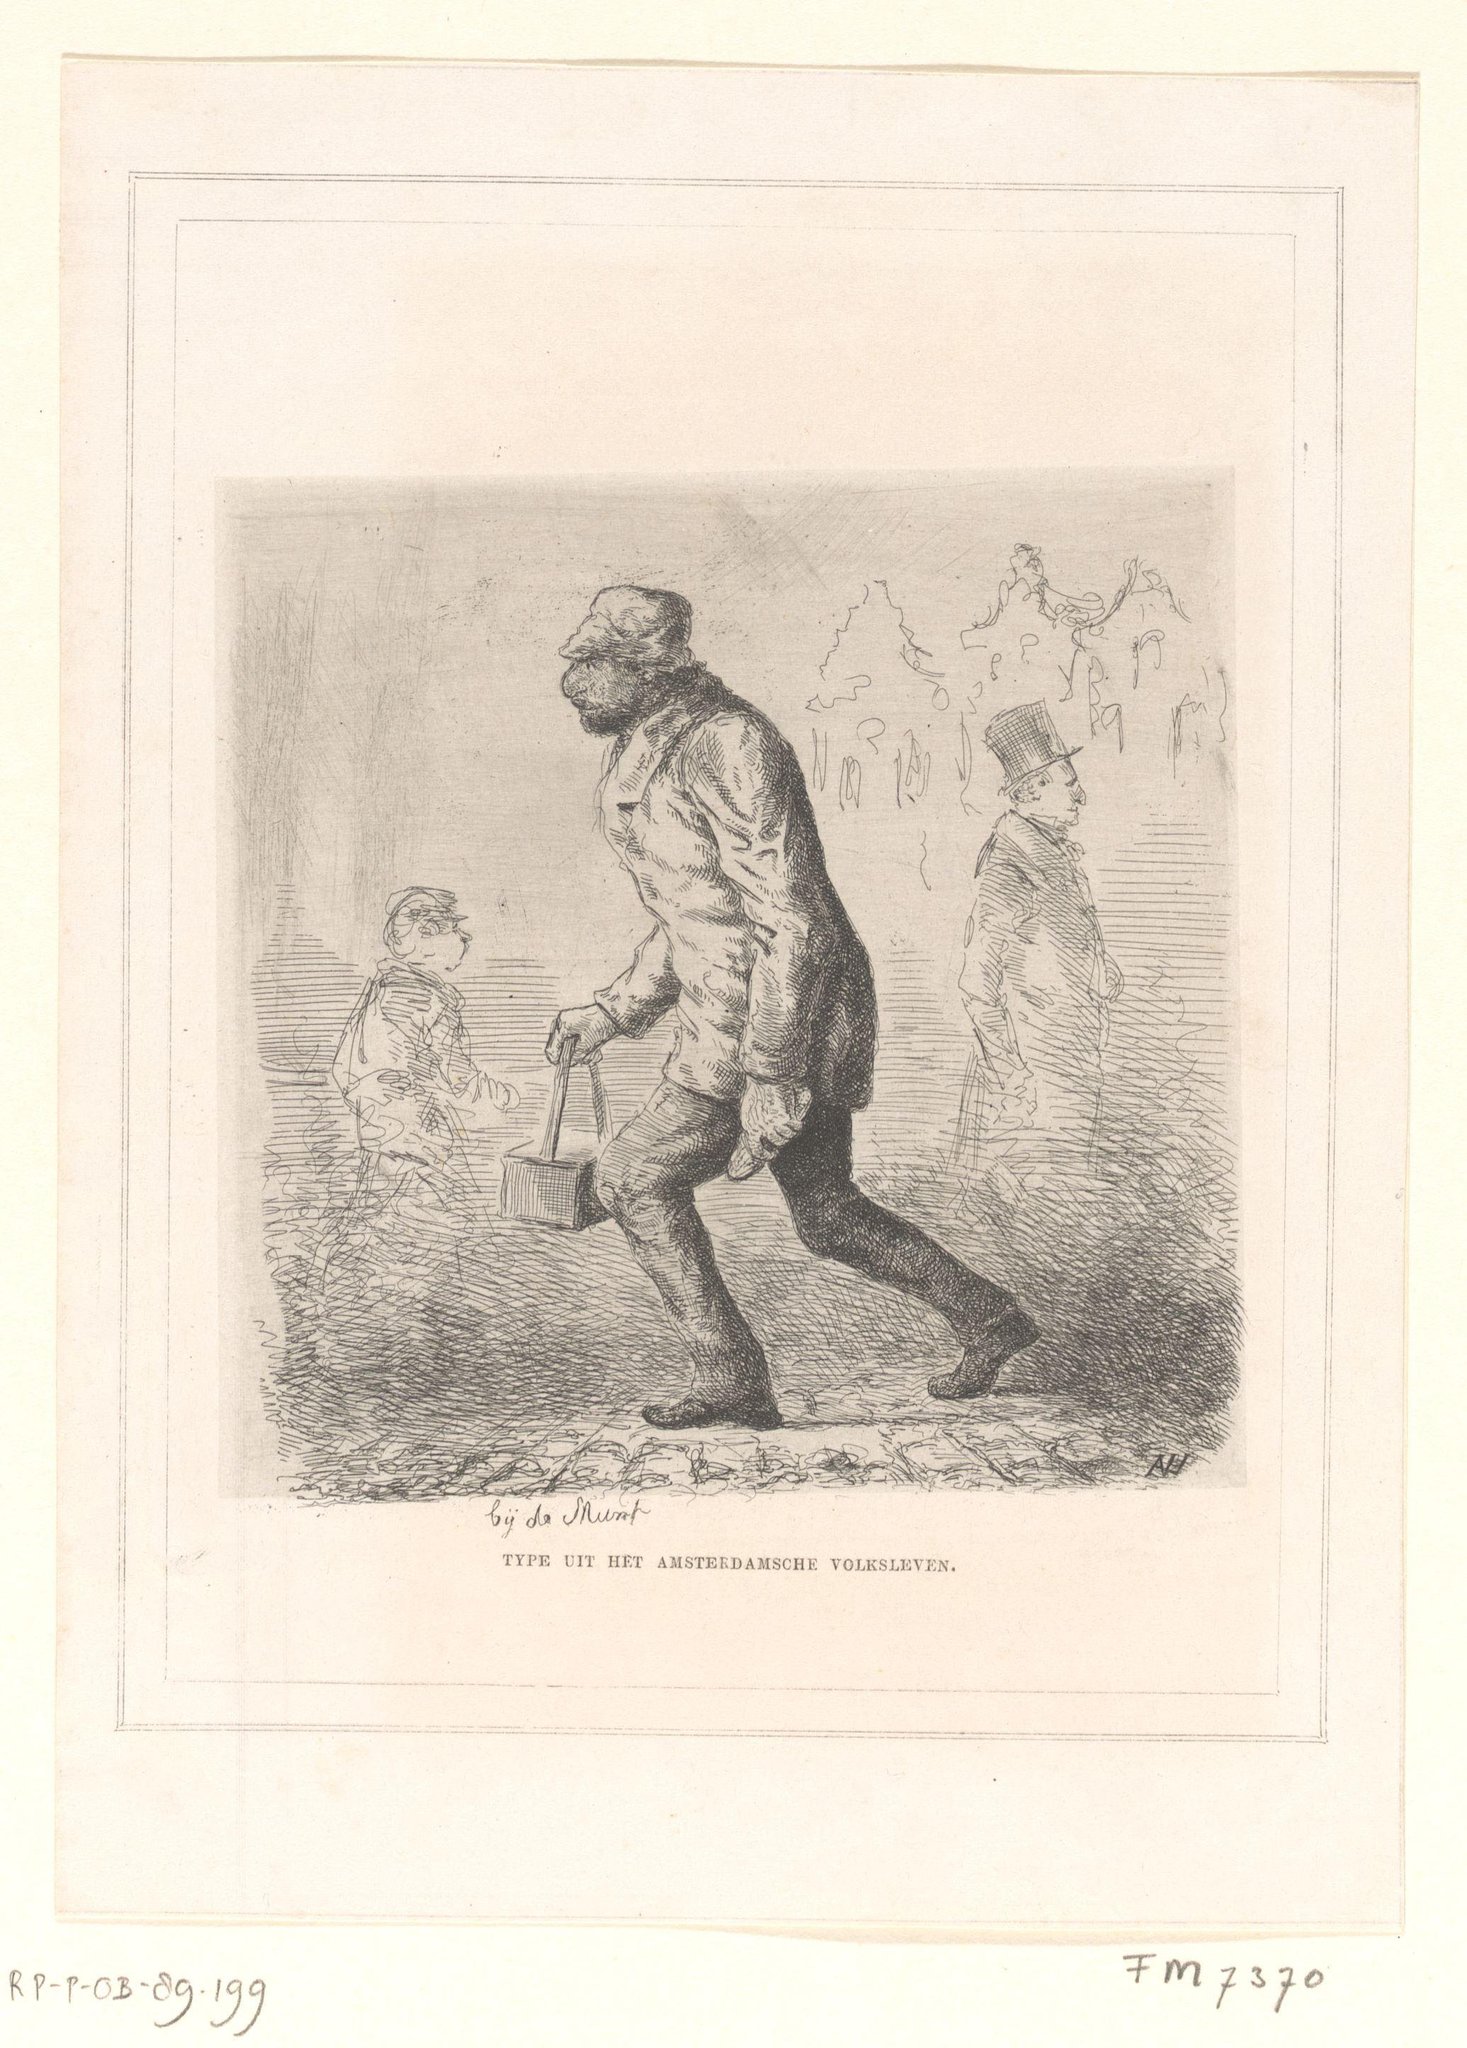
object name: print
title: bij de Munt / Type uit het Amsterdamsche volksleven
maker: alexander ver huell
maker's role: draughtsman, print maker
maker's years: 1822-1897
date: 1860-1869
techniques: printmaking, etching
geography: netherlands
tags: accessories ~ shoes, e.g. insole, shoehorn, shoe-polish, street-trader, the jews, jewish life, amsterdam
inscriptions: collector's mark: Lugt 2228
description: De joodse schoenpoetser die werkzaam was bij de Munt te Amsterdam, 1864.